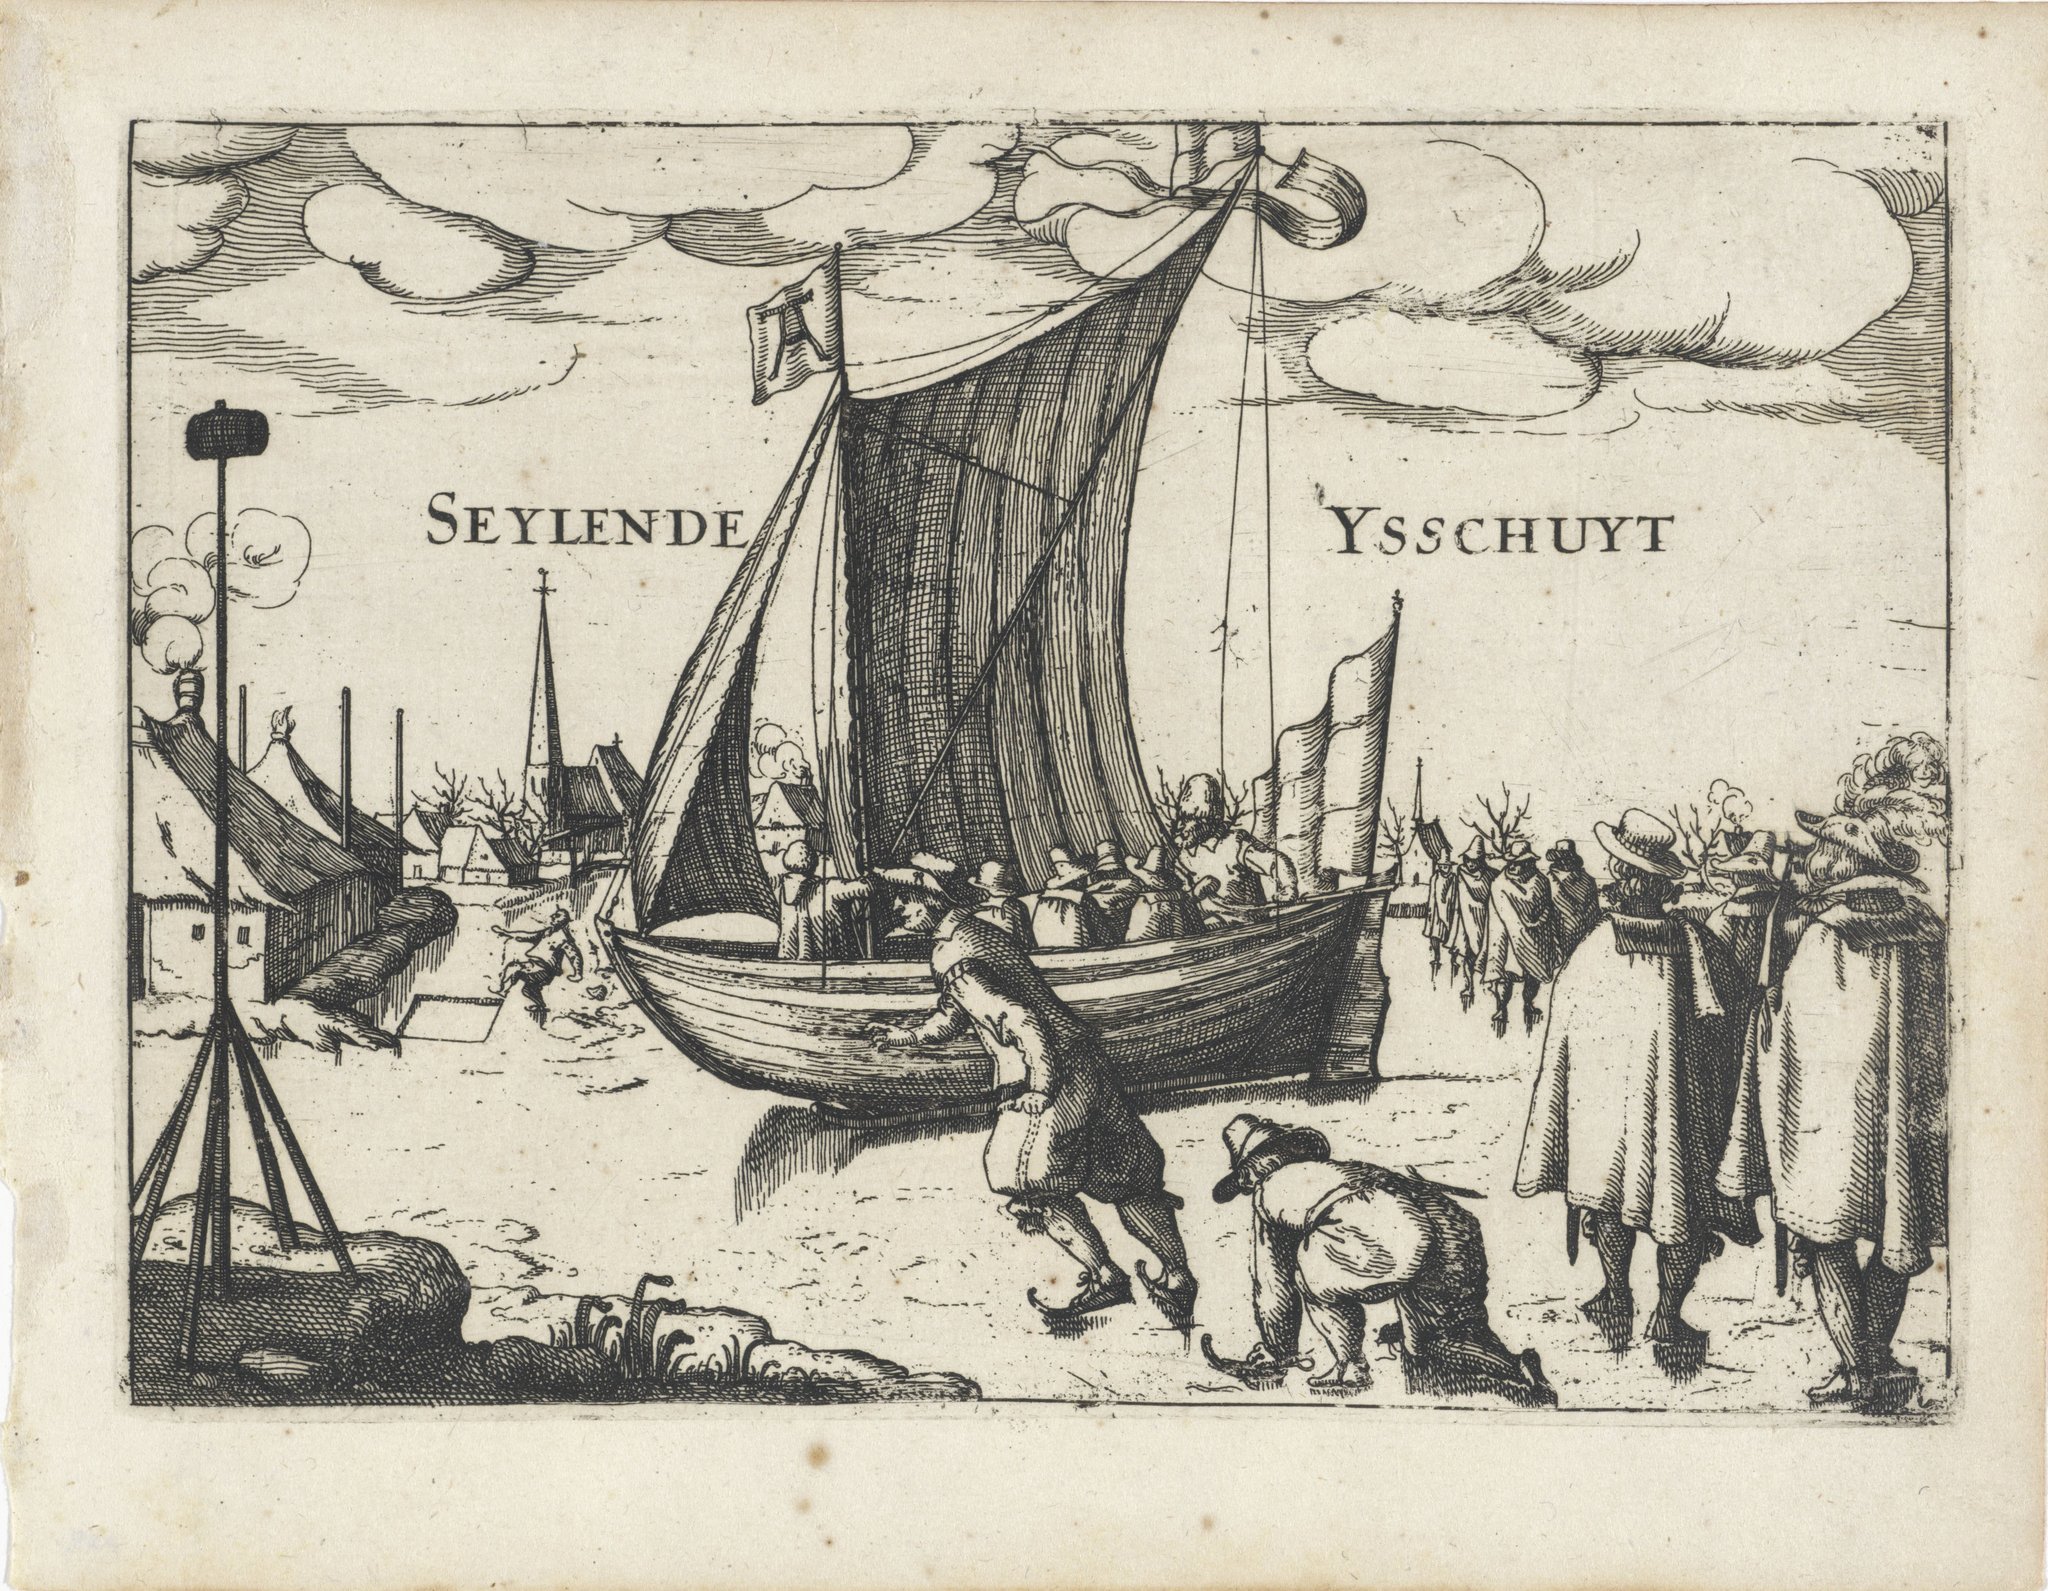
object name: print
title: Schuit en zeilwagens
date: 1608-1615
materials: paper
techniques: etching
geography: netherlands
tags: ice-sailing (winter sports), skates (winter sports)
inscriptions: collector's mark: ‘R: MVS’ Lugt 2228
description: Onbeschreven pendant van de ''Seylende windwagen' toegeschreven aan Claes Jansz. Visscher (Hollstein Dutch, dl. 38, p. 14, nr. 15). Deze ets is door Simon beschreven als mogelijk geëtst door Pieter van der Keere naar een verloren origineel van Visscher (Simon, p. 100, noot 163). Een vergelijkbare ijsschuit is afgebeeld in de randen van twee door Visscher vervaardigde kaarten (Hollstein nrs. 219 en 221).